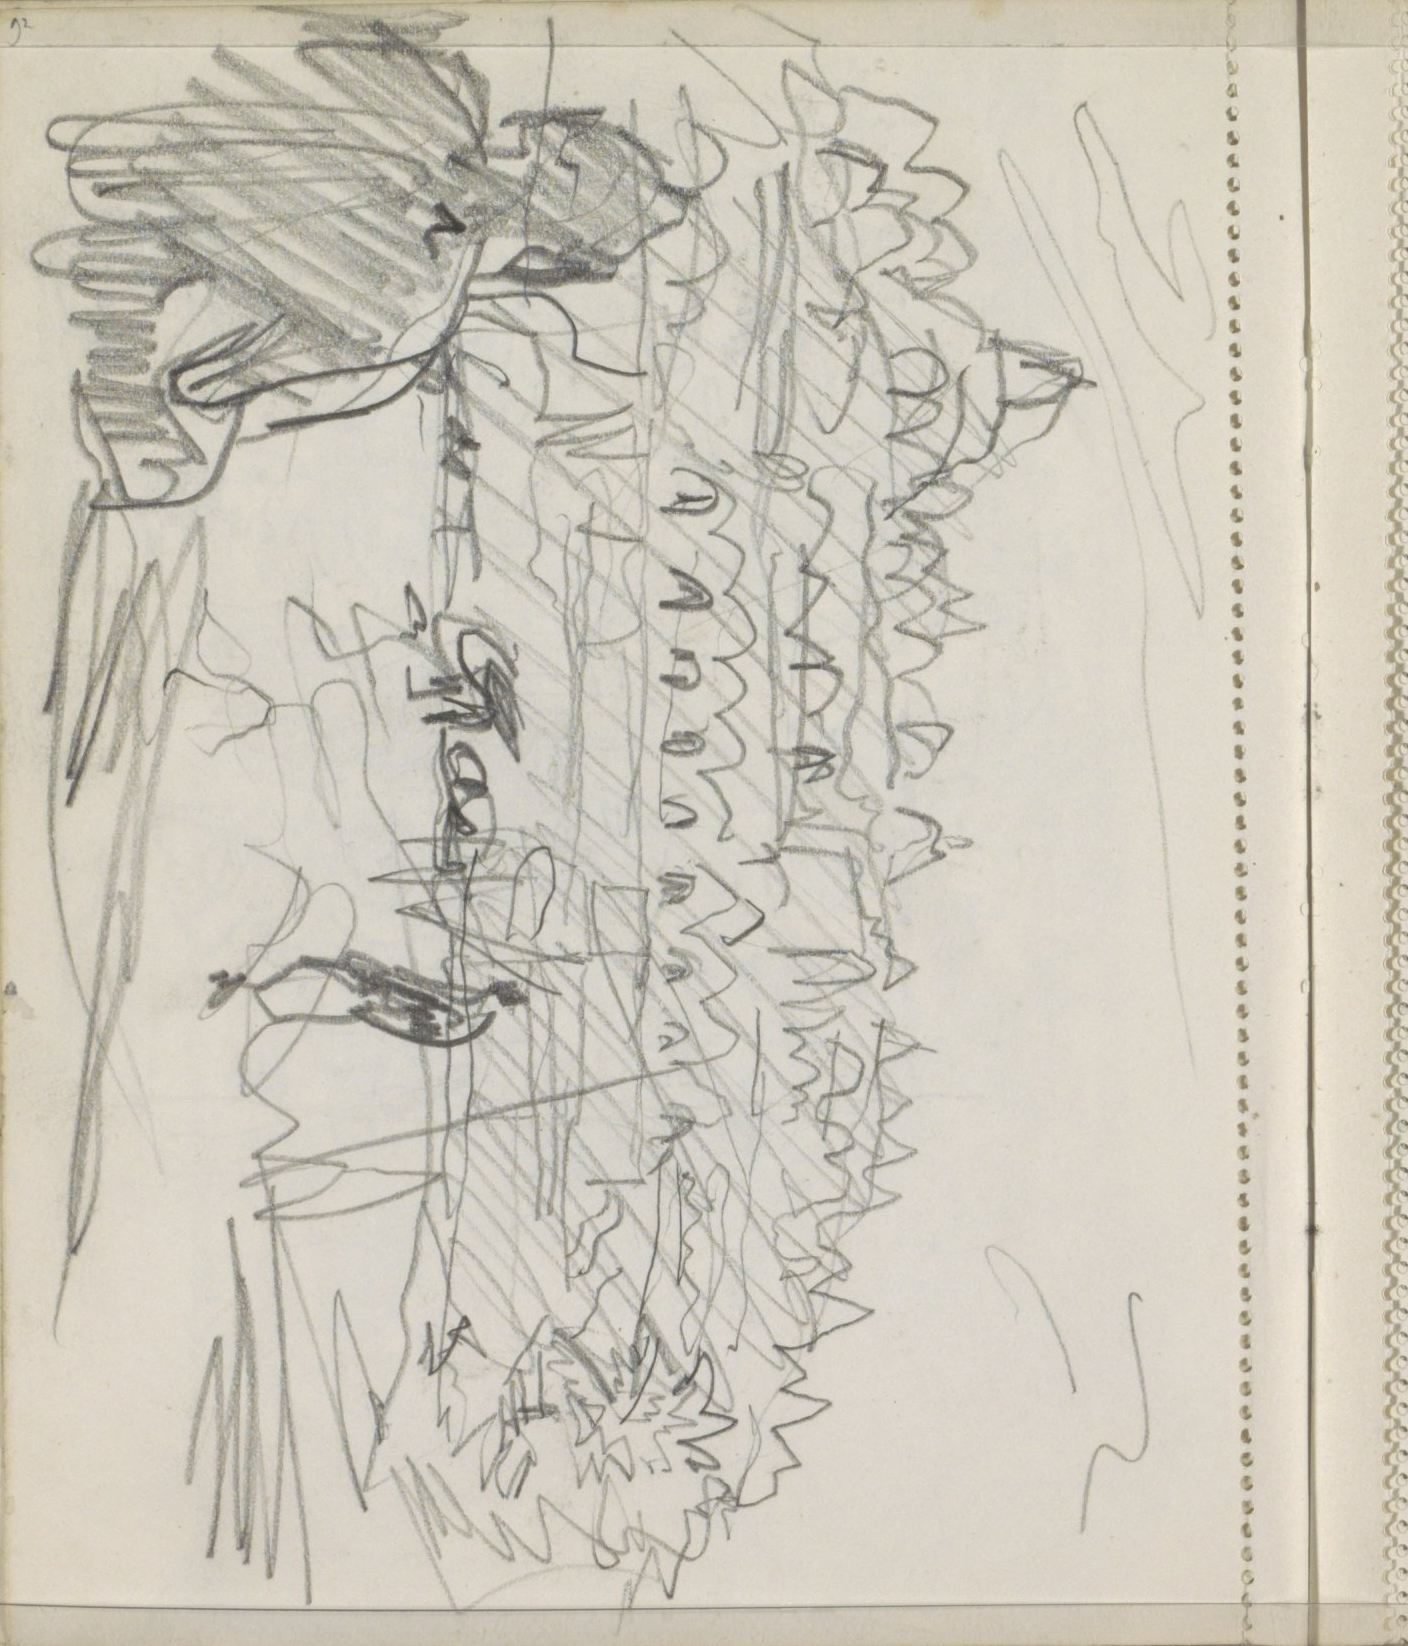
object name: sketchbook leaf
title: Borobudur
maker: marius bauer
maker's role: draughtsman, print maker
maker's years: 1867-1932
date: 1925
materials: paper, pencil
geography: java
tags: flight of steps, places and objects of worship ~ hinduism, buddhism, jainism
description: Pagina 92 uit een schetsboek met 67 bladen.